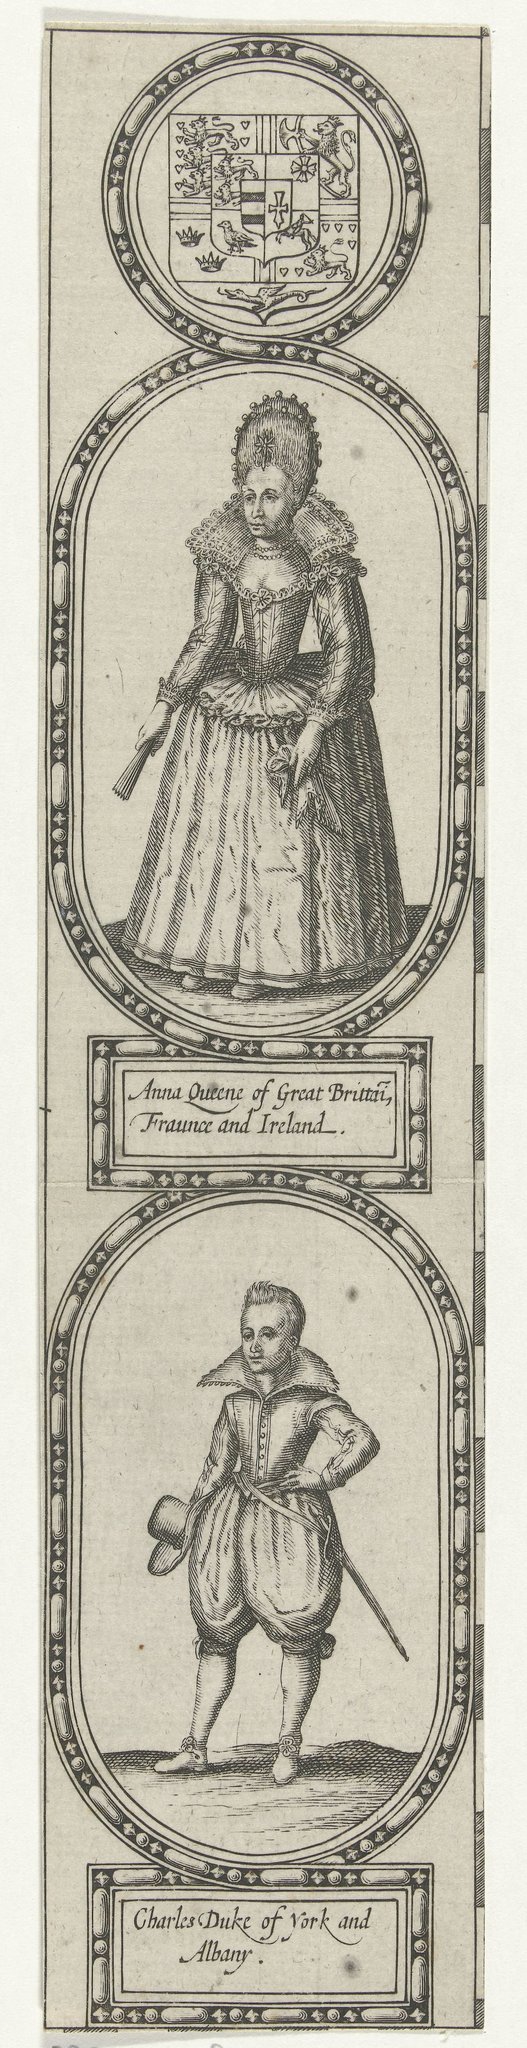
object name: book illustration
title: Portretten van Anna van Denemarken en Karel I van Engeland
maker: jodocus hondius (i)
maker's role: print maker, publisher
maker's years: 1563-1612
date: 1611-1612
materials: paper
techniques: engraving, letterpress printing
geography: london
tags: karel i (koning van engeland)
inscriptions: collector's mark: Lugt 2228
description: Portret ten voeten uit van (boven) Anna van Denemarken in een cartouche met onder het portret haar naam en titel in twee regels in het Engels en (onder) Karel I van Engeland, ten voeten uit, in een cartouche met onder het portret zijjn naam en titel in twee regels in het Engels.